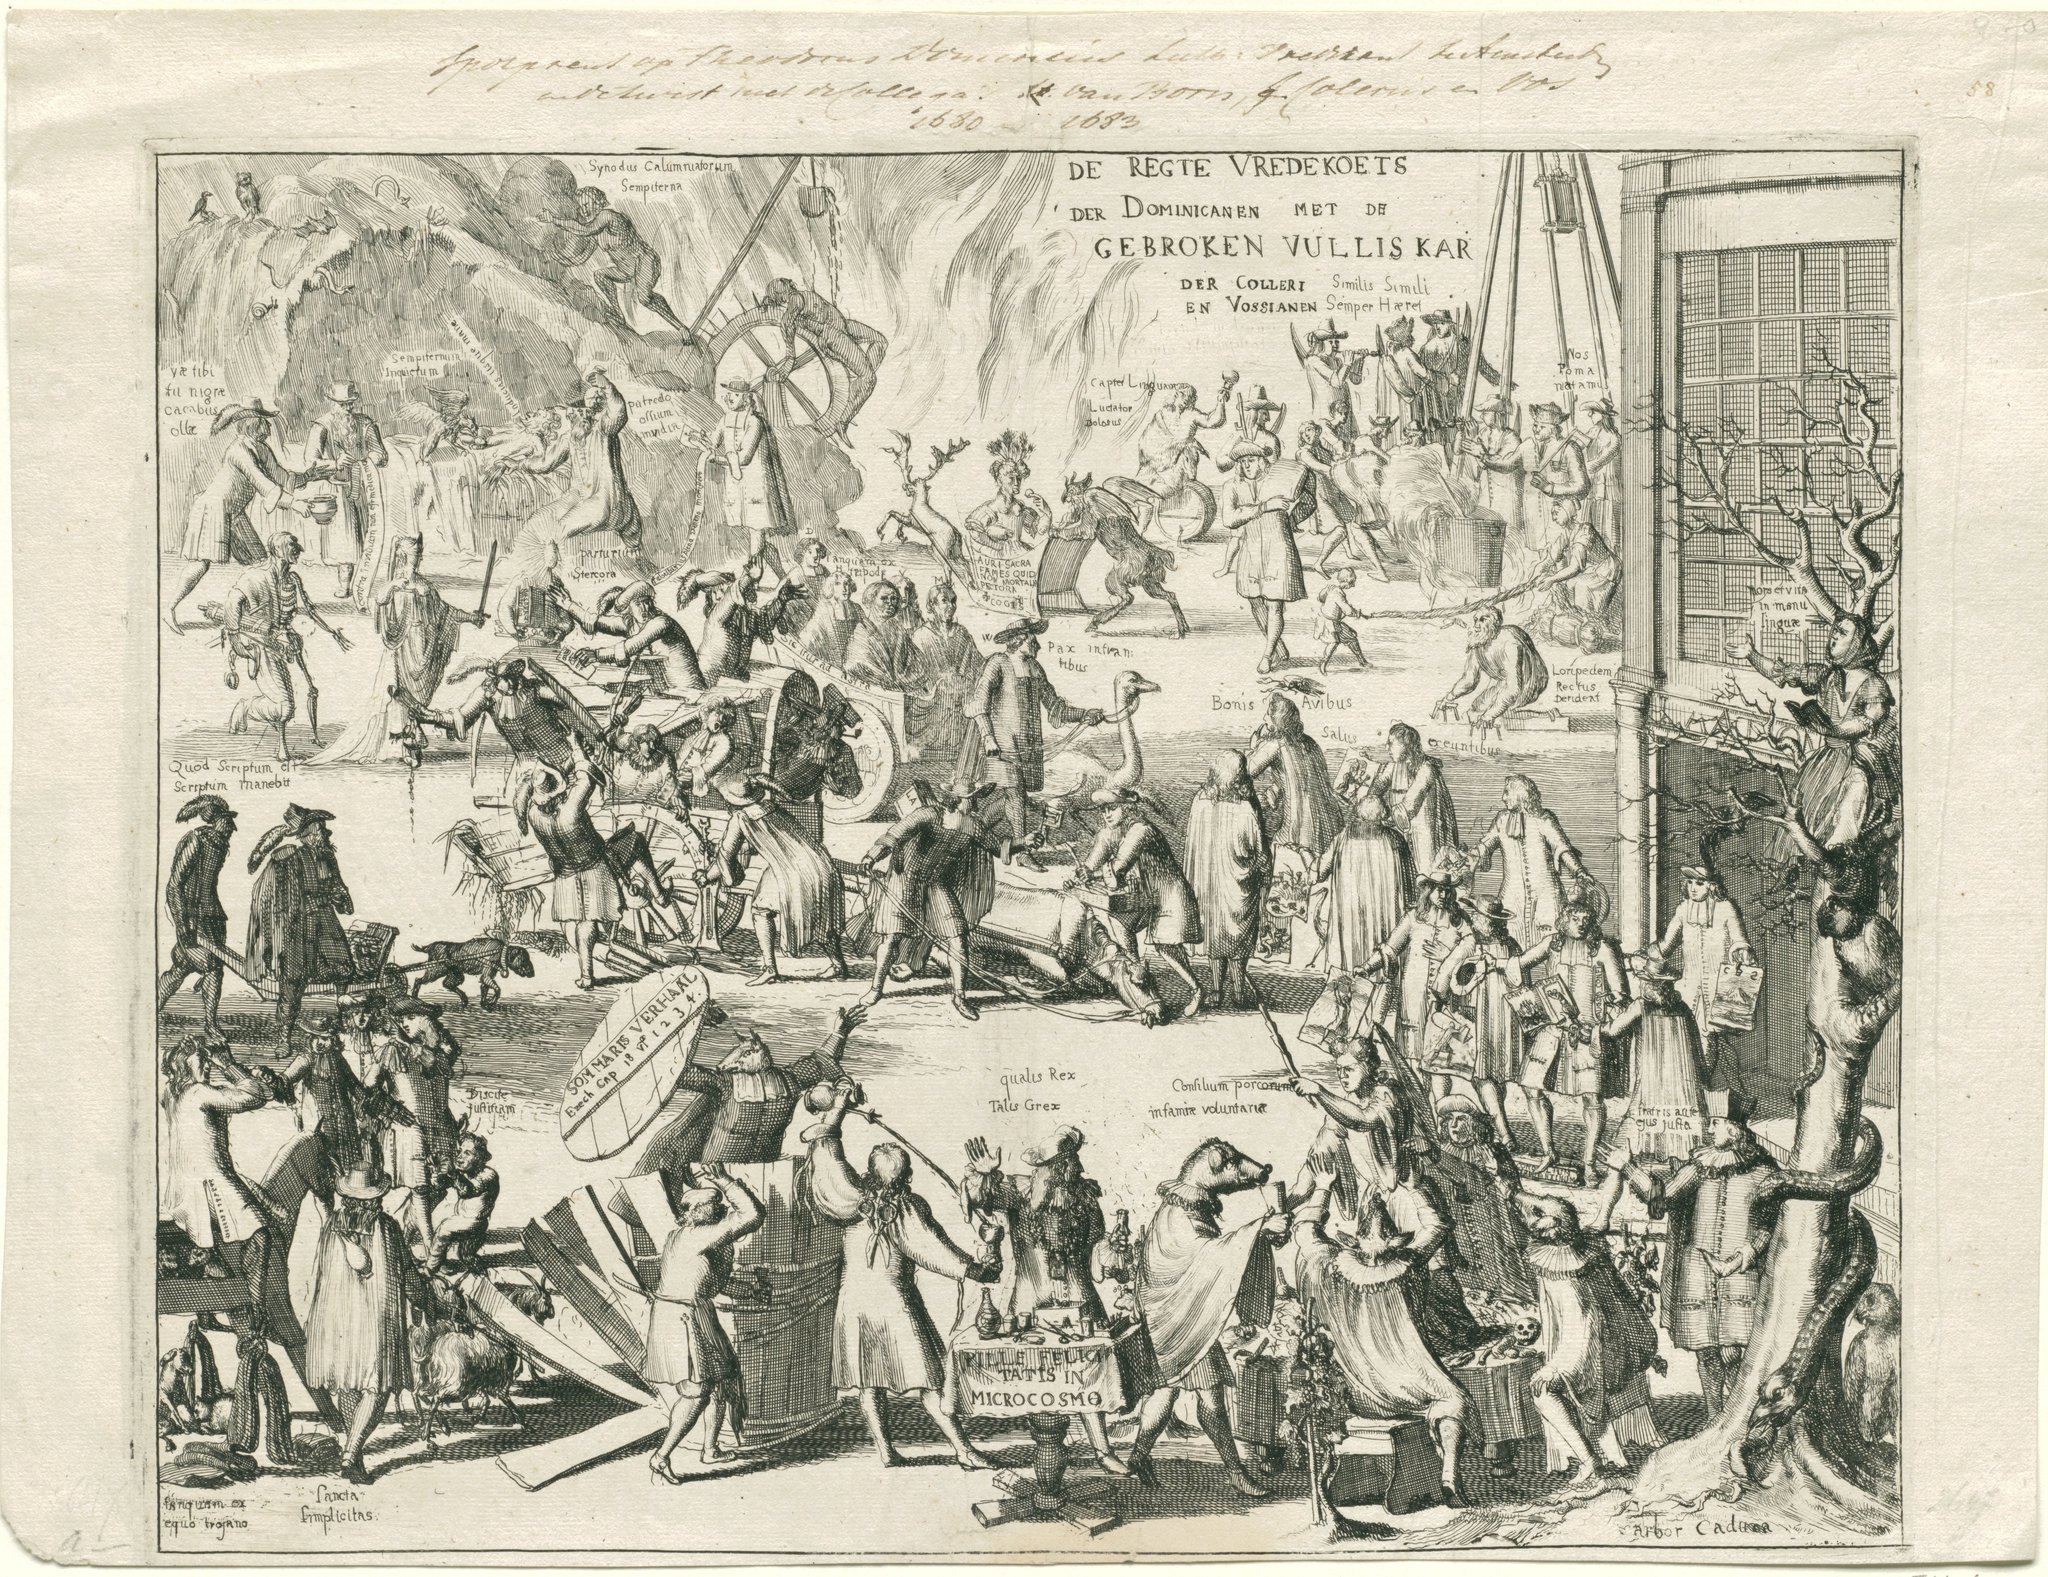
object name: print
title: De Regte Vredekoets der Dominicanen met de Gebroken Vulliskar der Colleri en Vossianen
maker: Anonymous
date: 1683-1684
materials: paper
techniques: etching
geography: northern netherlands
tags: johannes colerus (1647-1707), amsterdam, henricus vos, priest, martin luther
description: Spotprent op de lutherse kerktwisten te Amsterdam tussen de Hollandse (vrijzinnig) en de Duitse (rechtzinnig) richting binnen de lutherse gemeente en die een hoogtepunt bereiken in de strijd rond de aanstelling van de predikant Theodorus Dominicus te Amsterdam in 1683. In het midden van de voorstelling de vredeskar getrokken door een zwaan waarin Melanchton, Luther, Hoppe en Dominicus rijden. Links daarvan de gebroken vuilniswagen waarin Johannes Colerus (Köhler) en Henricus Vos rijden. De wagens begeven zich in de richting van de lutherse kerk rechts vooraan. Op de voorgrond veel meer figuren, Circe met de Westfaalse varkens, de bakkersvrouw zingend in de dorre boom en de kuiperijen van Henricus Vos. Op de achtergrond de hel (links) en het gewone volk dat zich bezig houdt met heien en touwvlechten (rechts).